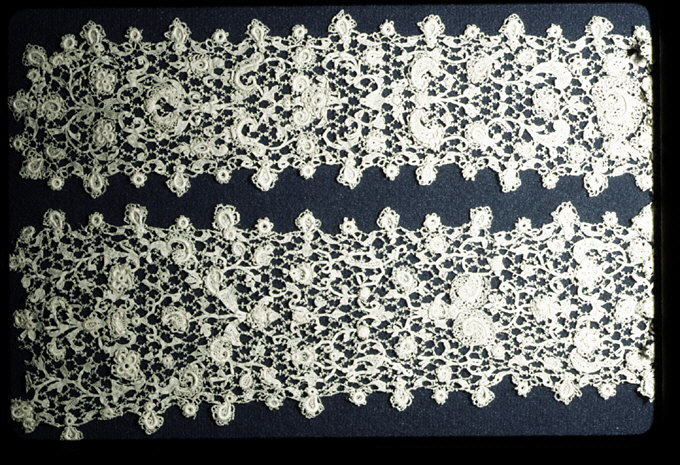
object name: lappet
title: Lappet (one of a pair)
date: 1701-1733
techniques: lace